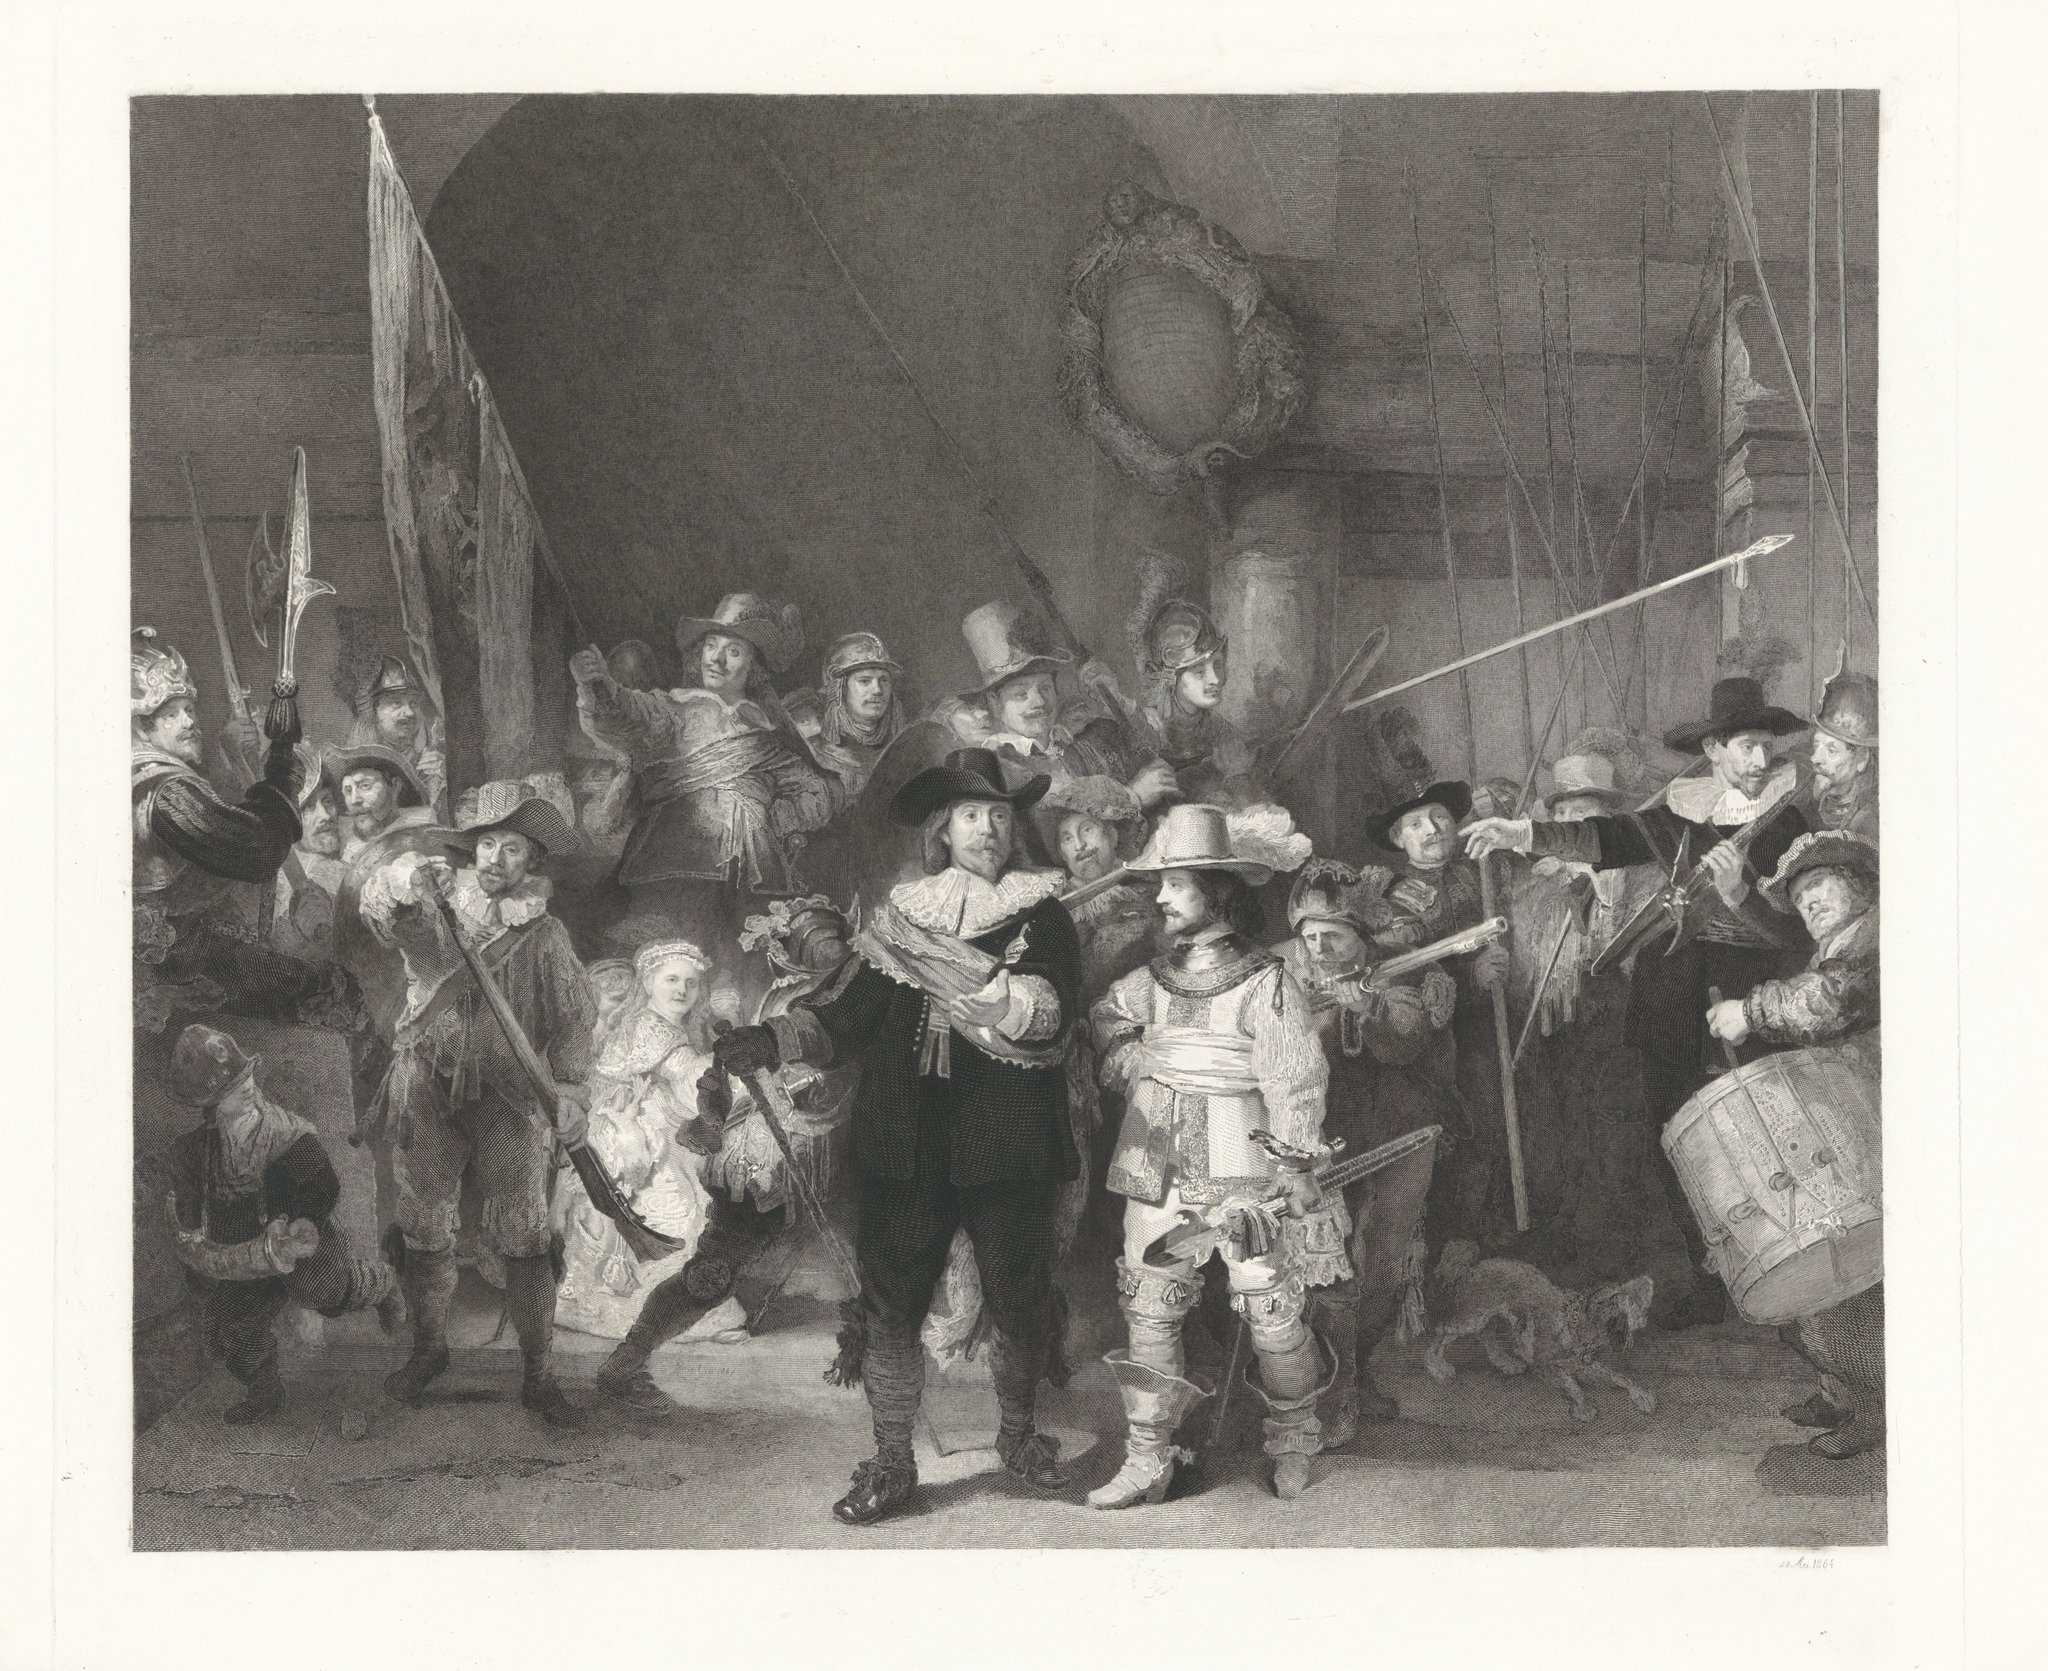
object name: print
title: Het korporaalschap van kapitein Frans Banninck Cocq en luitenant Willem van Ruytenburch, bekend als de 'Nachtwacht'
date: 1864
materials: paper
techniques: engraving, etching, roulette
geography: amsterdam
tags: proclamation of peace, celebration meal, feast, banquet, festivities on events of national importance, picture, painting, land forces (+ citizen soldiery, civil guard, citizen militia), historical events and situations, dog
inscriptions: collector's mark: Lugt 2228